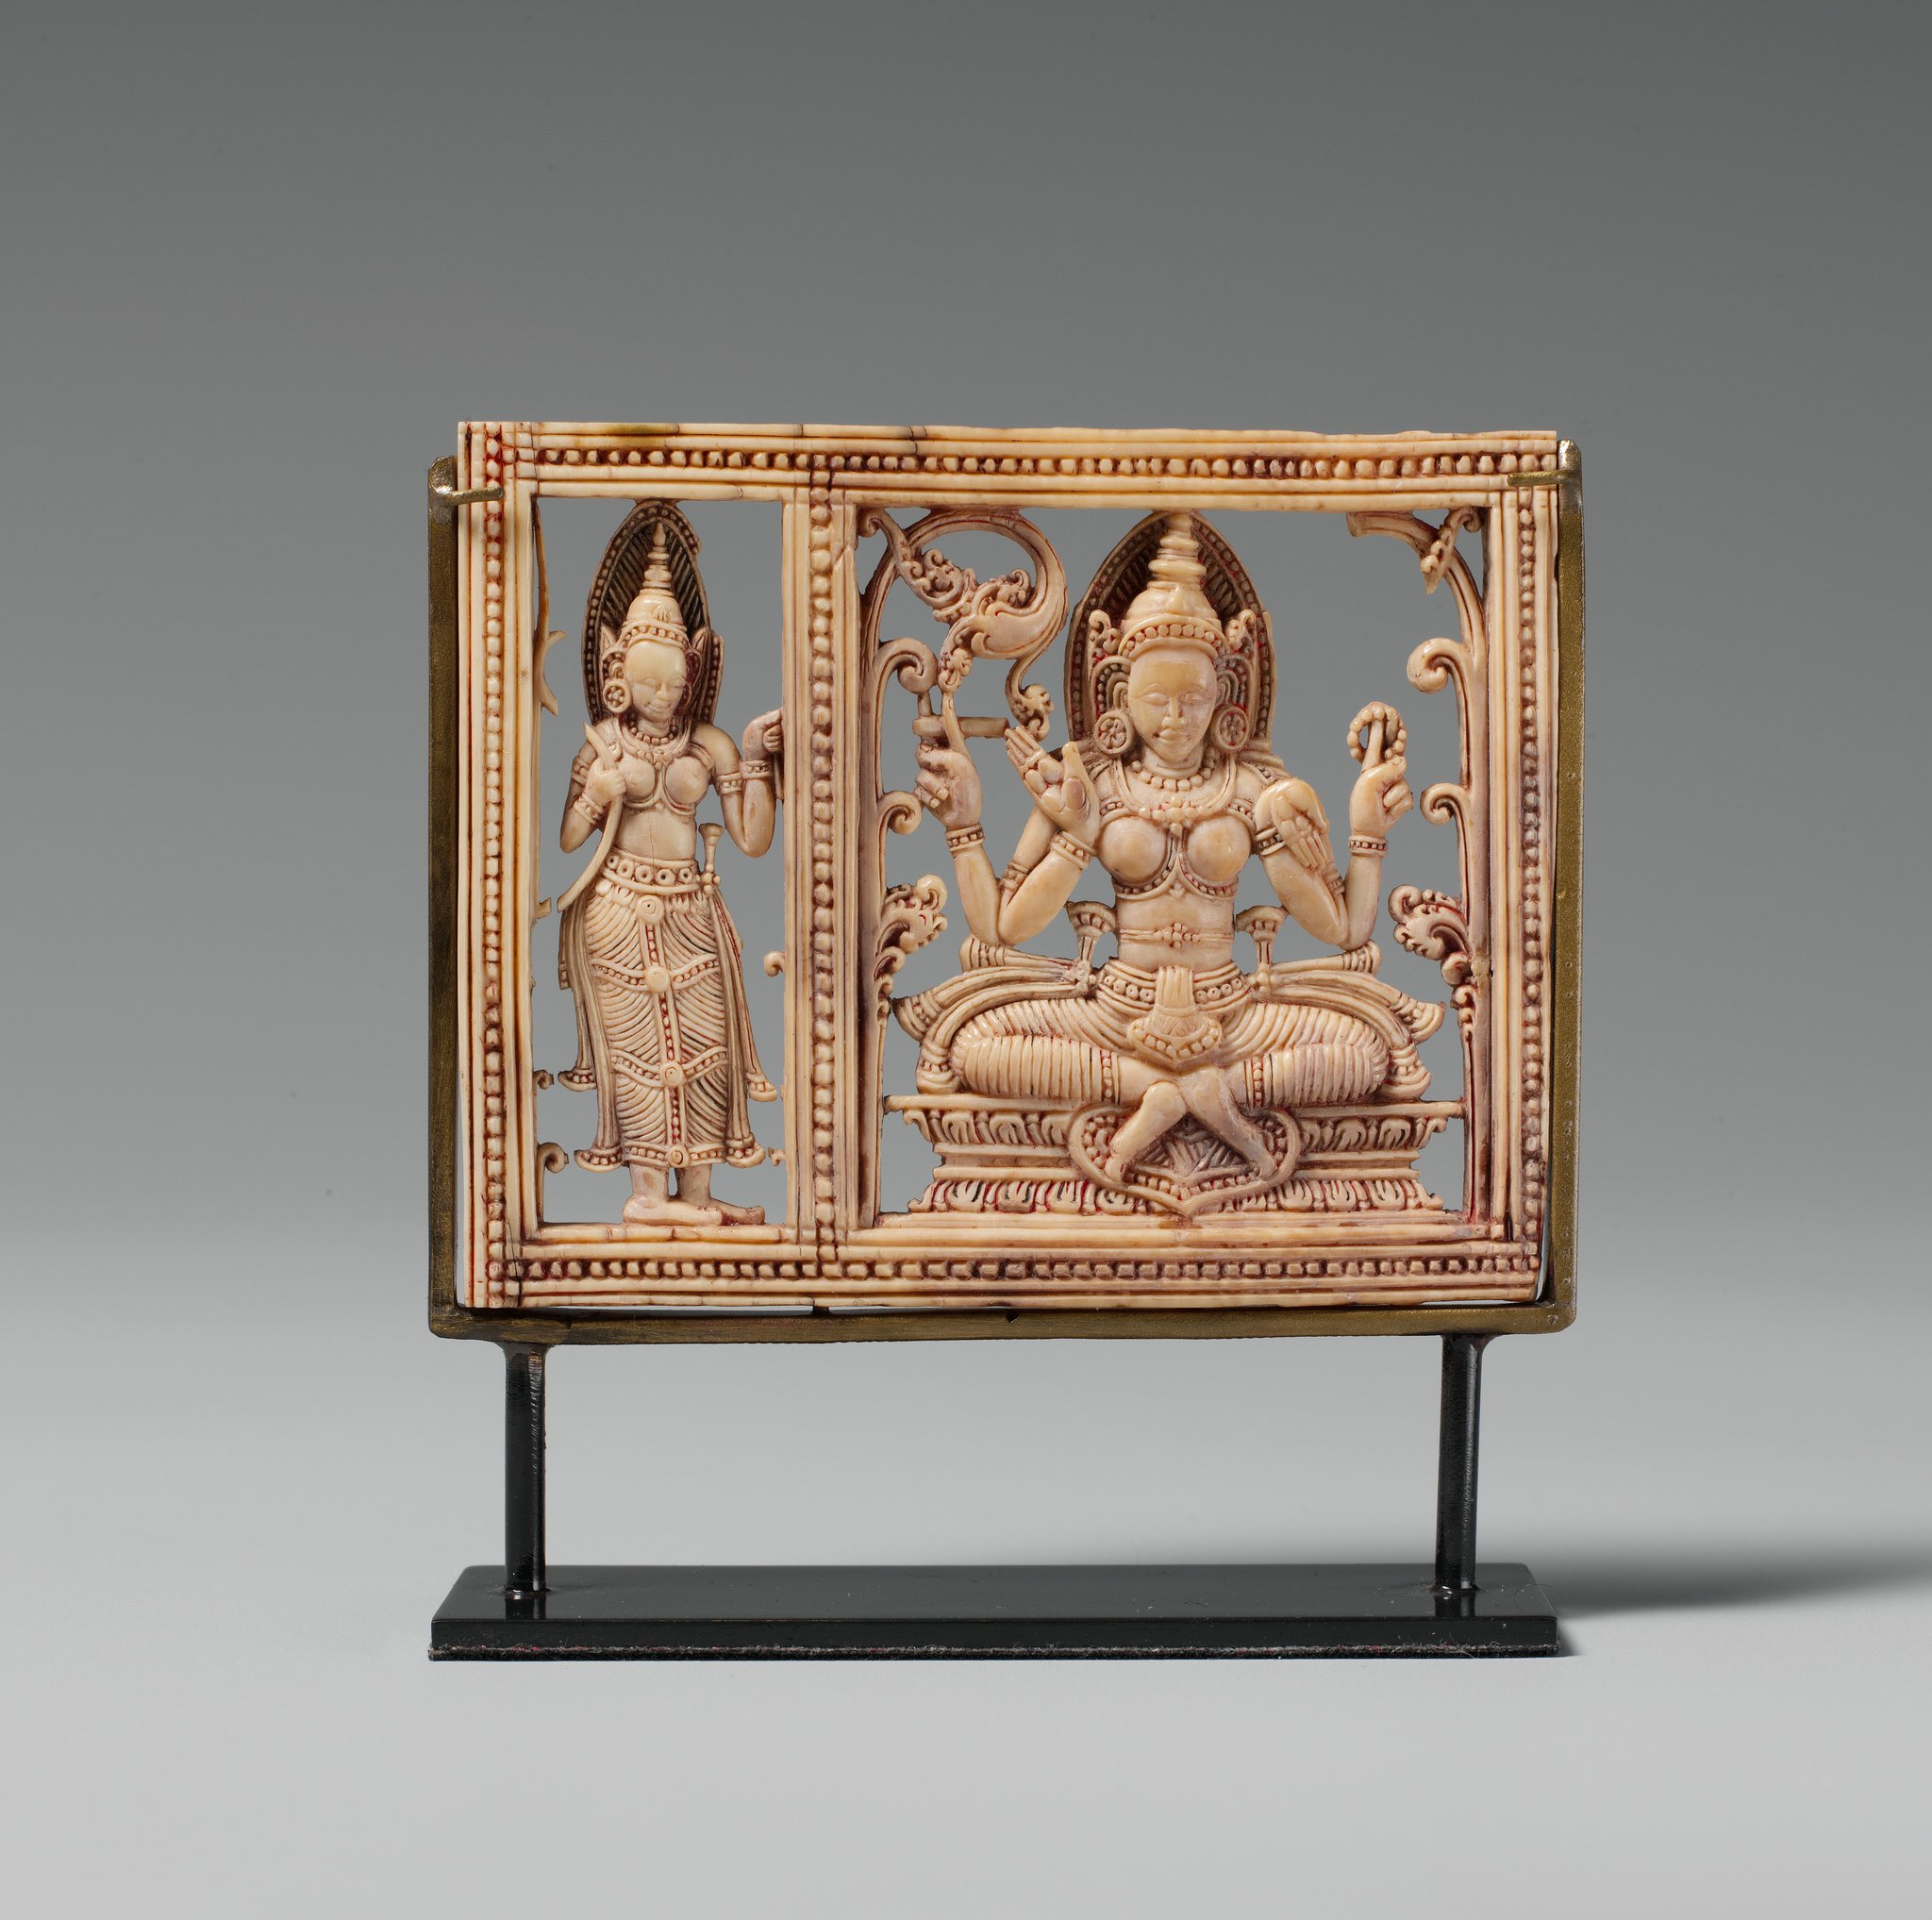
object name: plaque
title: Plaque with Seated Dhanada-Tara and Attendant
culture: sri lankan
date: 1601-1700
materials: ivory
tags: goddess